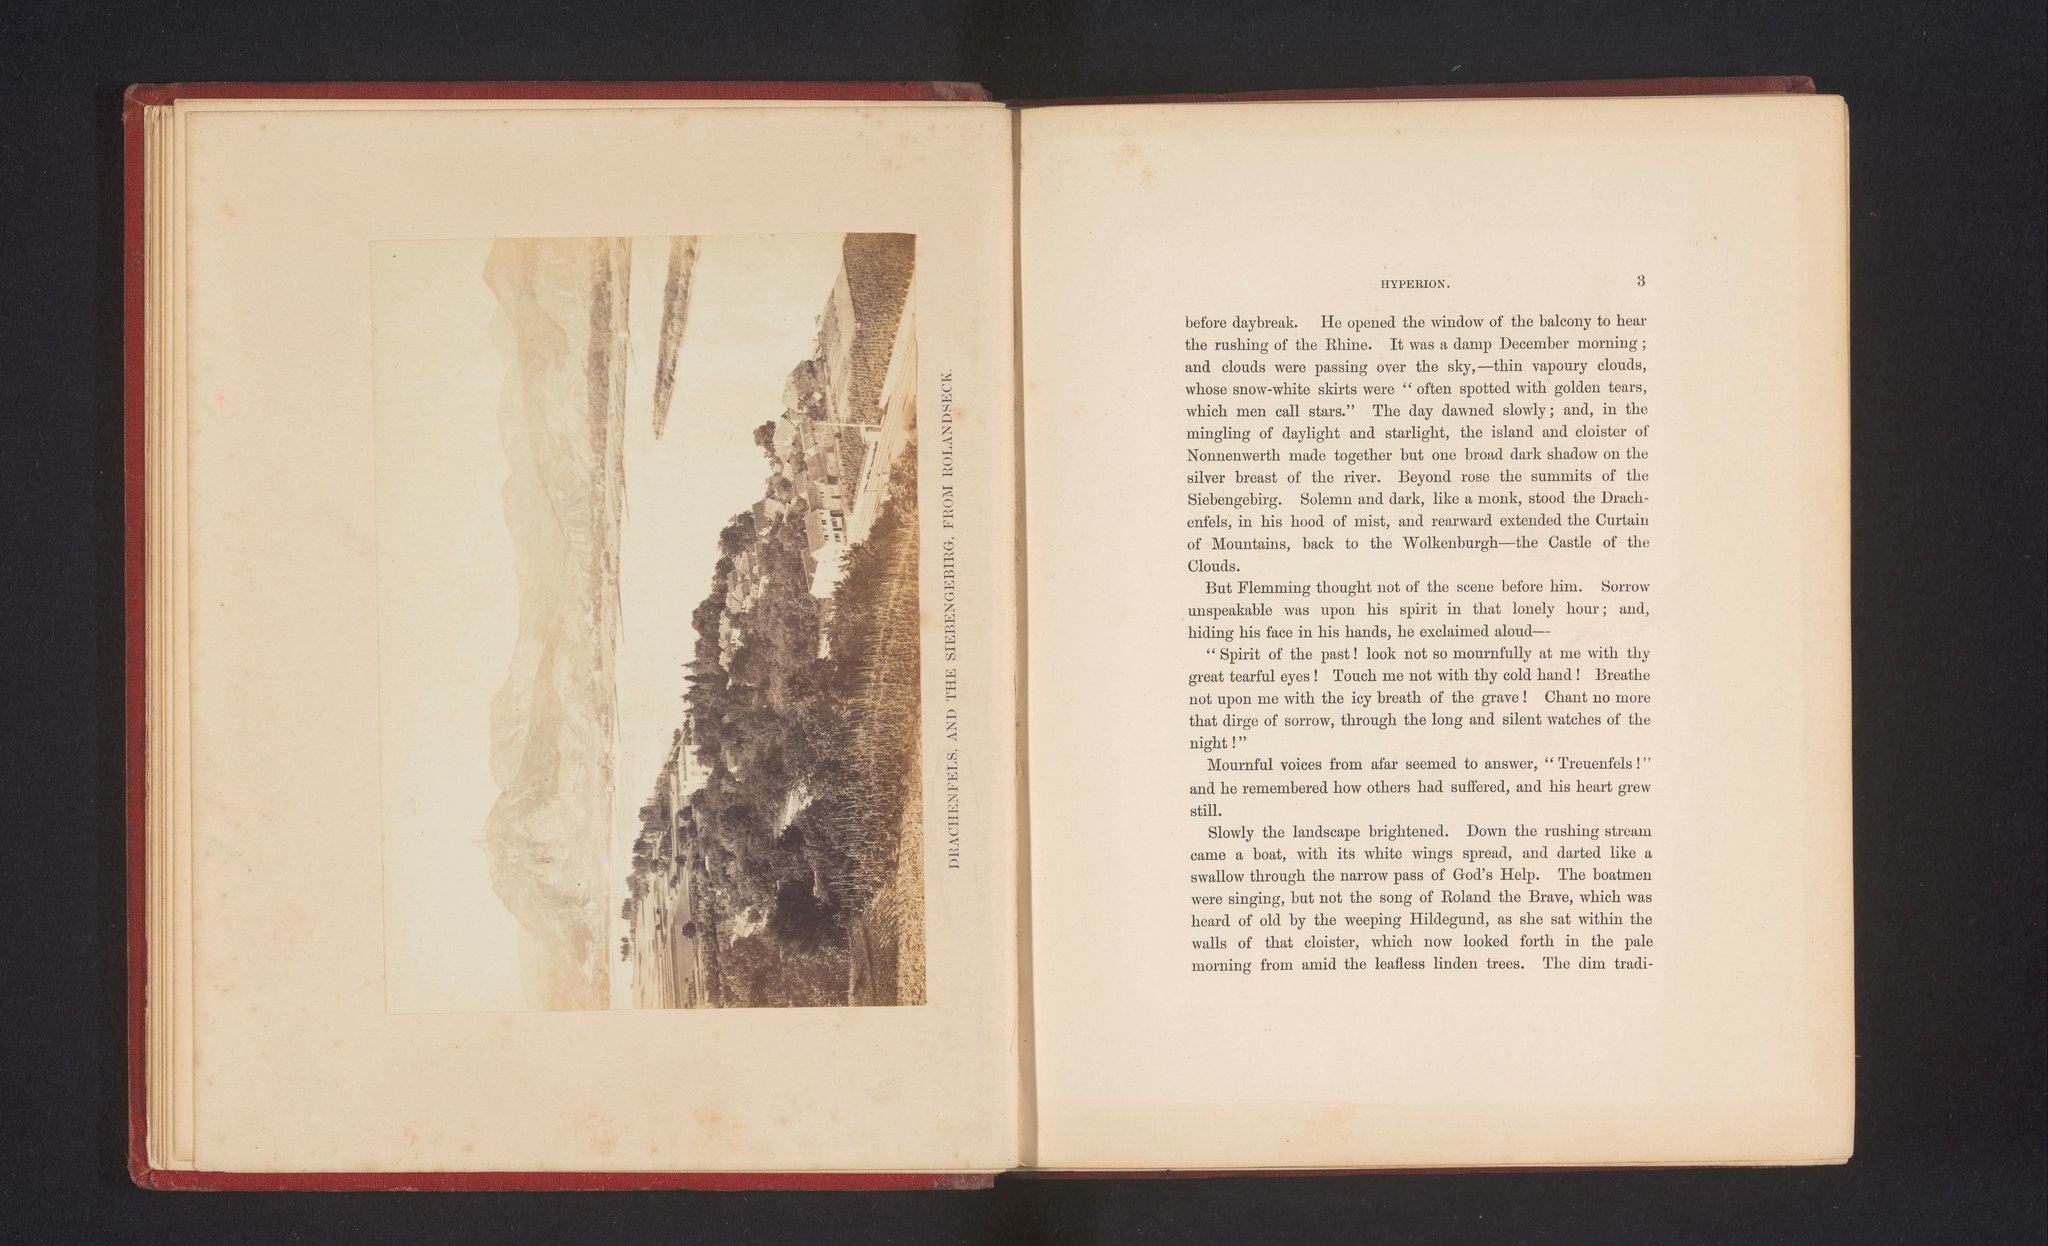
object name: page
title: Zevengebergte met de Drachenfels gezien vanaf Rolandseck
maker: francis frith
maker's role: publisher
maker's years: 1822-1898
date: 1855-1865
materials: photographic support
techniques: albumen print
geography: remagen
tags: mountain-top, peak